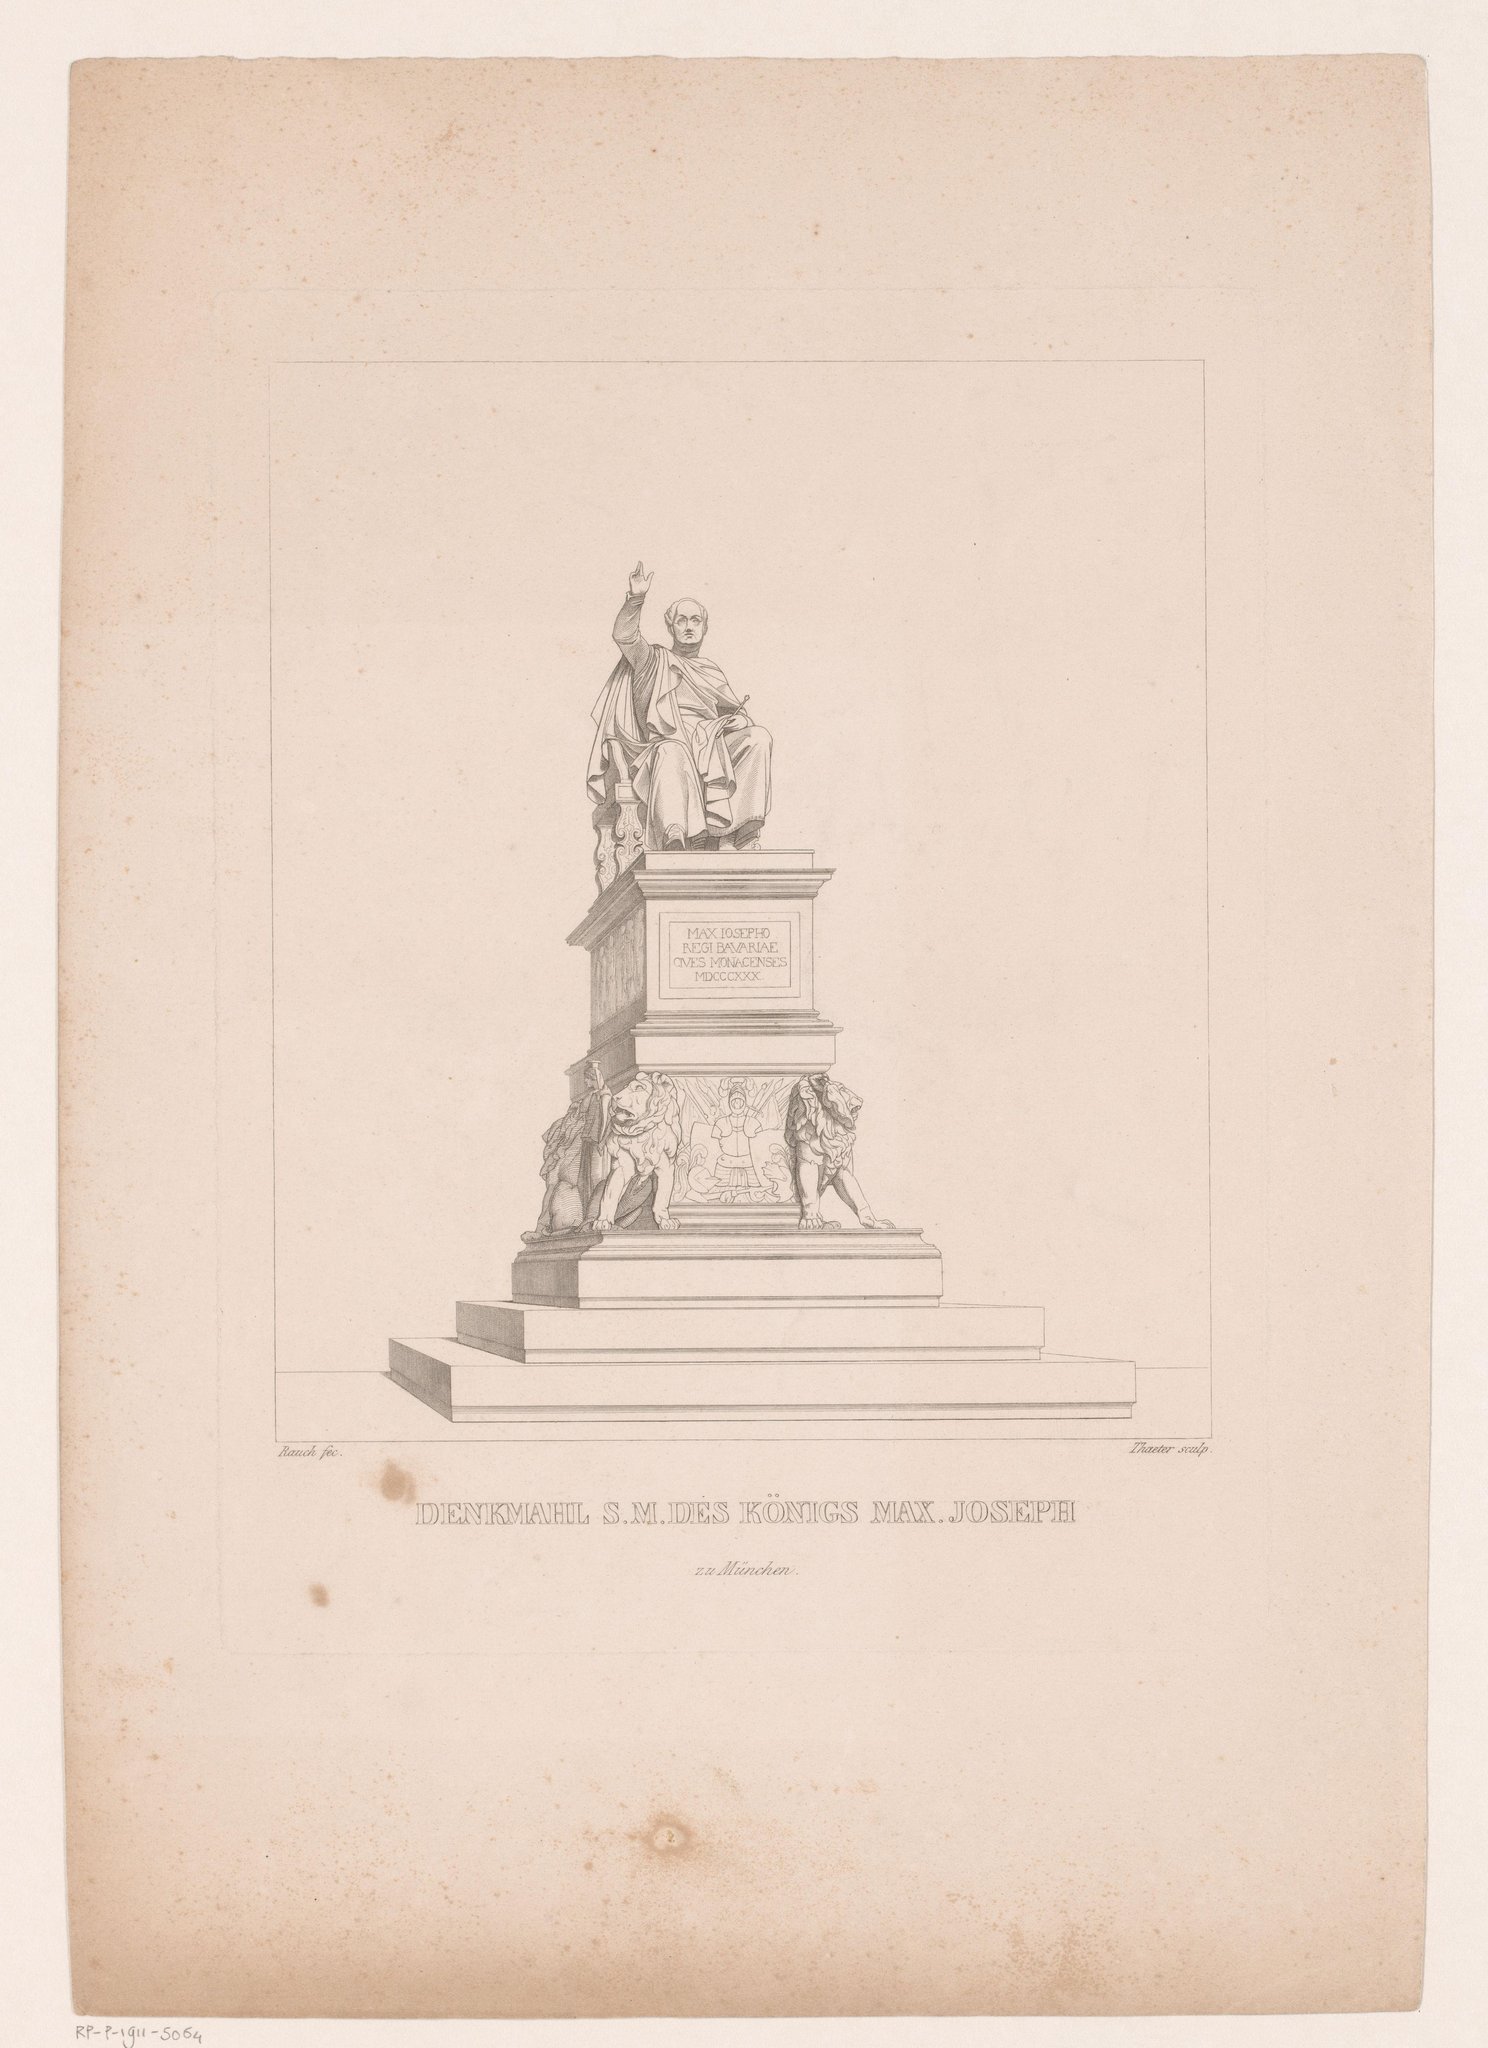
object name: print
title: Monument voor Maximiliaan I Jozef, koning van Beieren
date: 1835-1870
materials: paper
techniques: etching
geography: munich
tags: maximiliaan i jozef (koning van beieren), historical persons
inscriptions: collector's mark: Lugt 2228